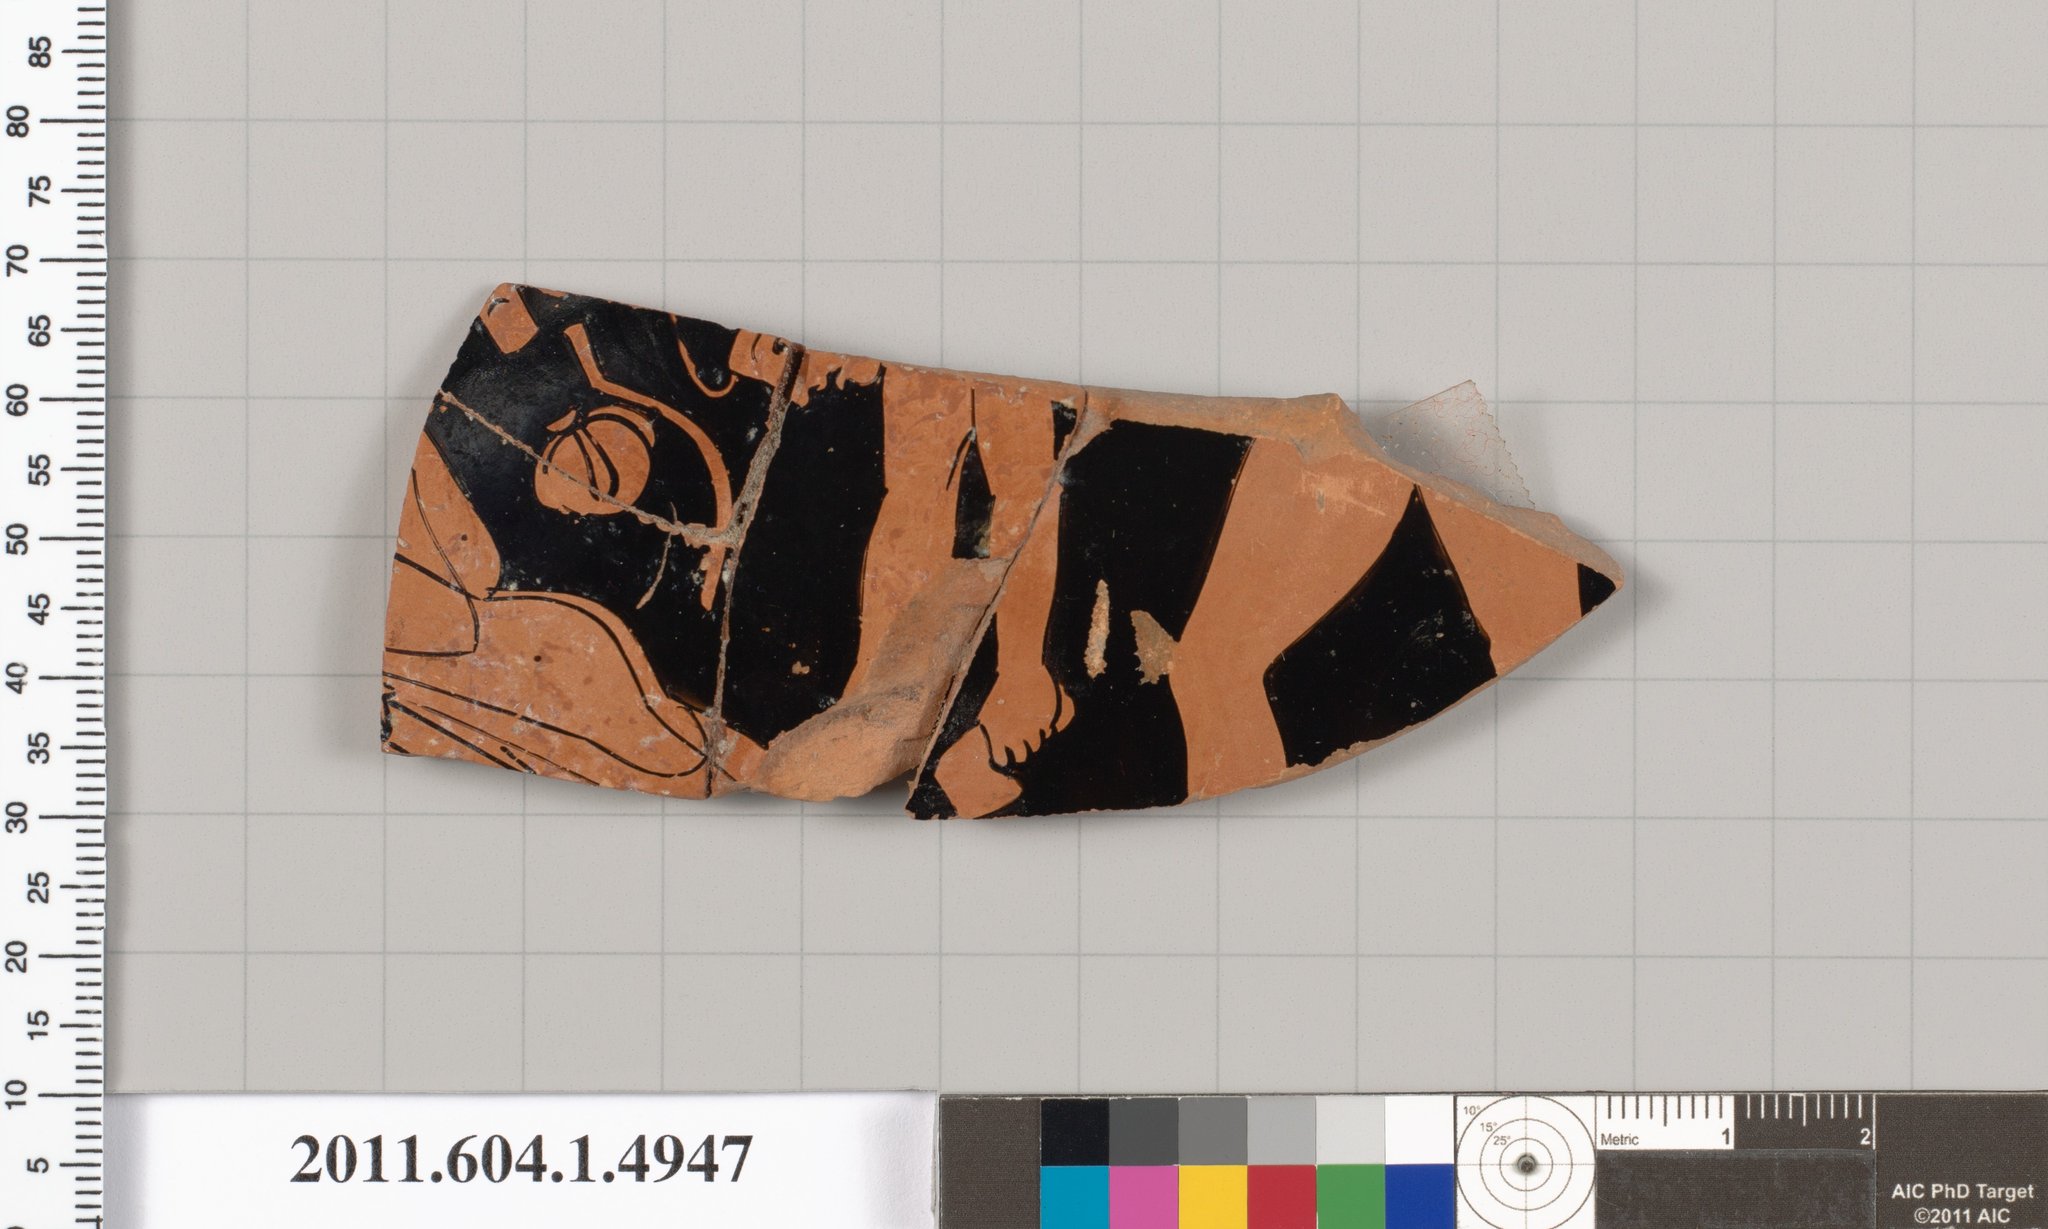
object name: kylix fragment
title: Terracotta fragment of a kylix (drinking cup)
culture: greek, attic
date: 490-470 BCE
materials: terracotta